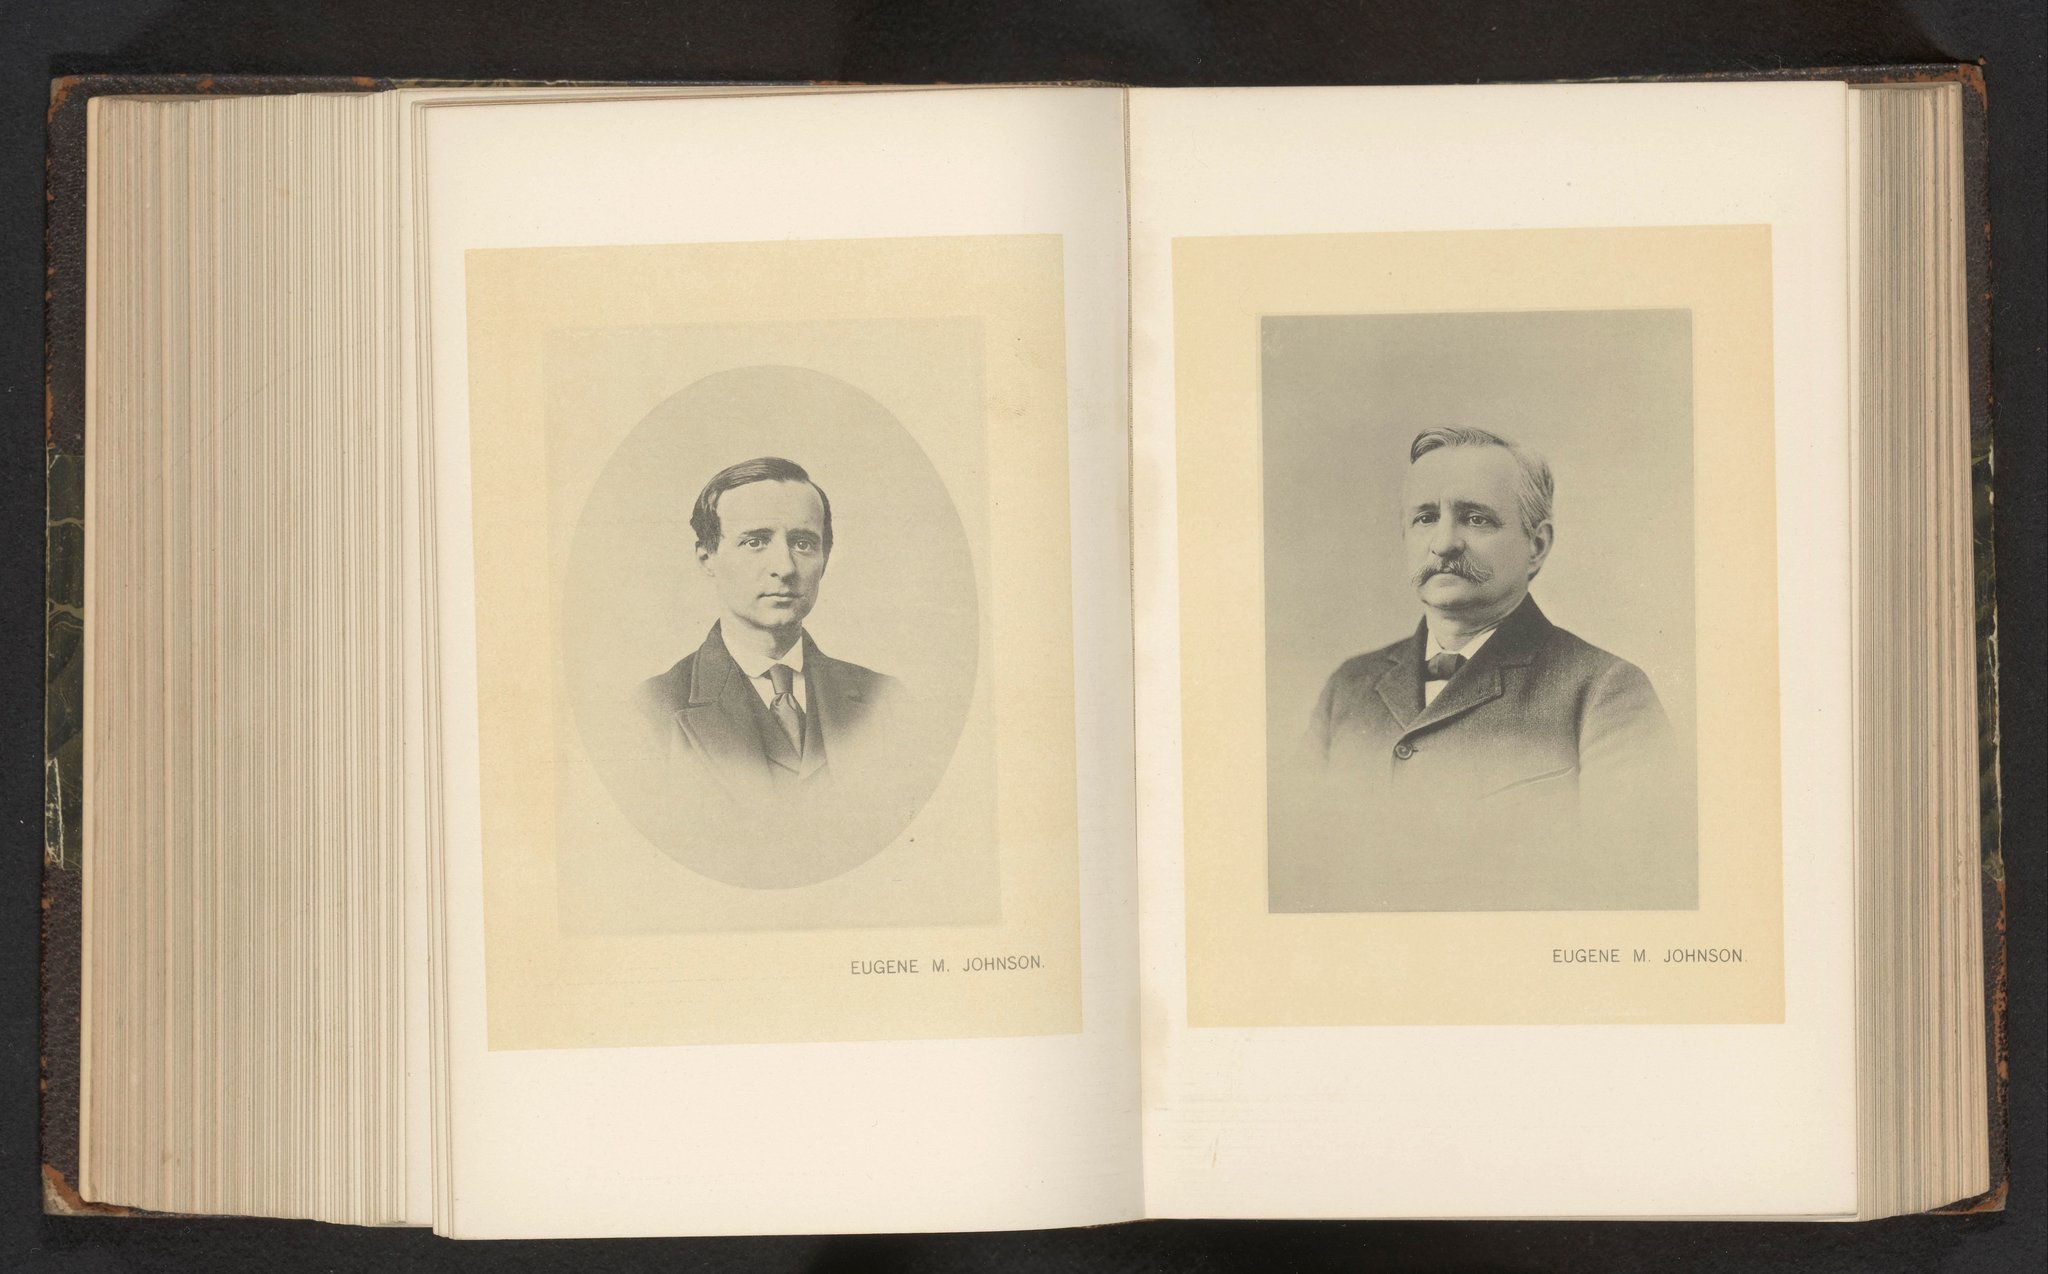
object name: photomechanical print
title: Eugene M. Johnson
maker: Anonymous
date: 1869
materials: paper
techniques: photoaquatint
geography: boston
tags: adult man